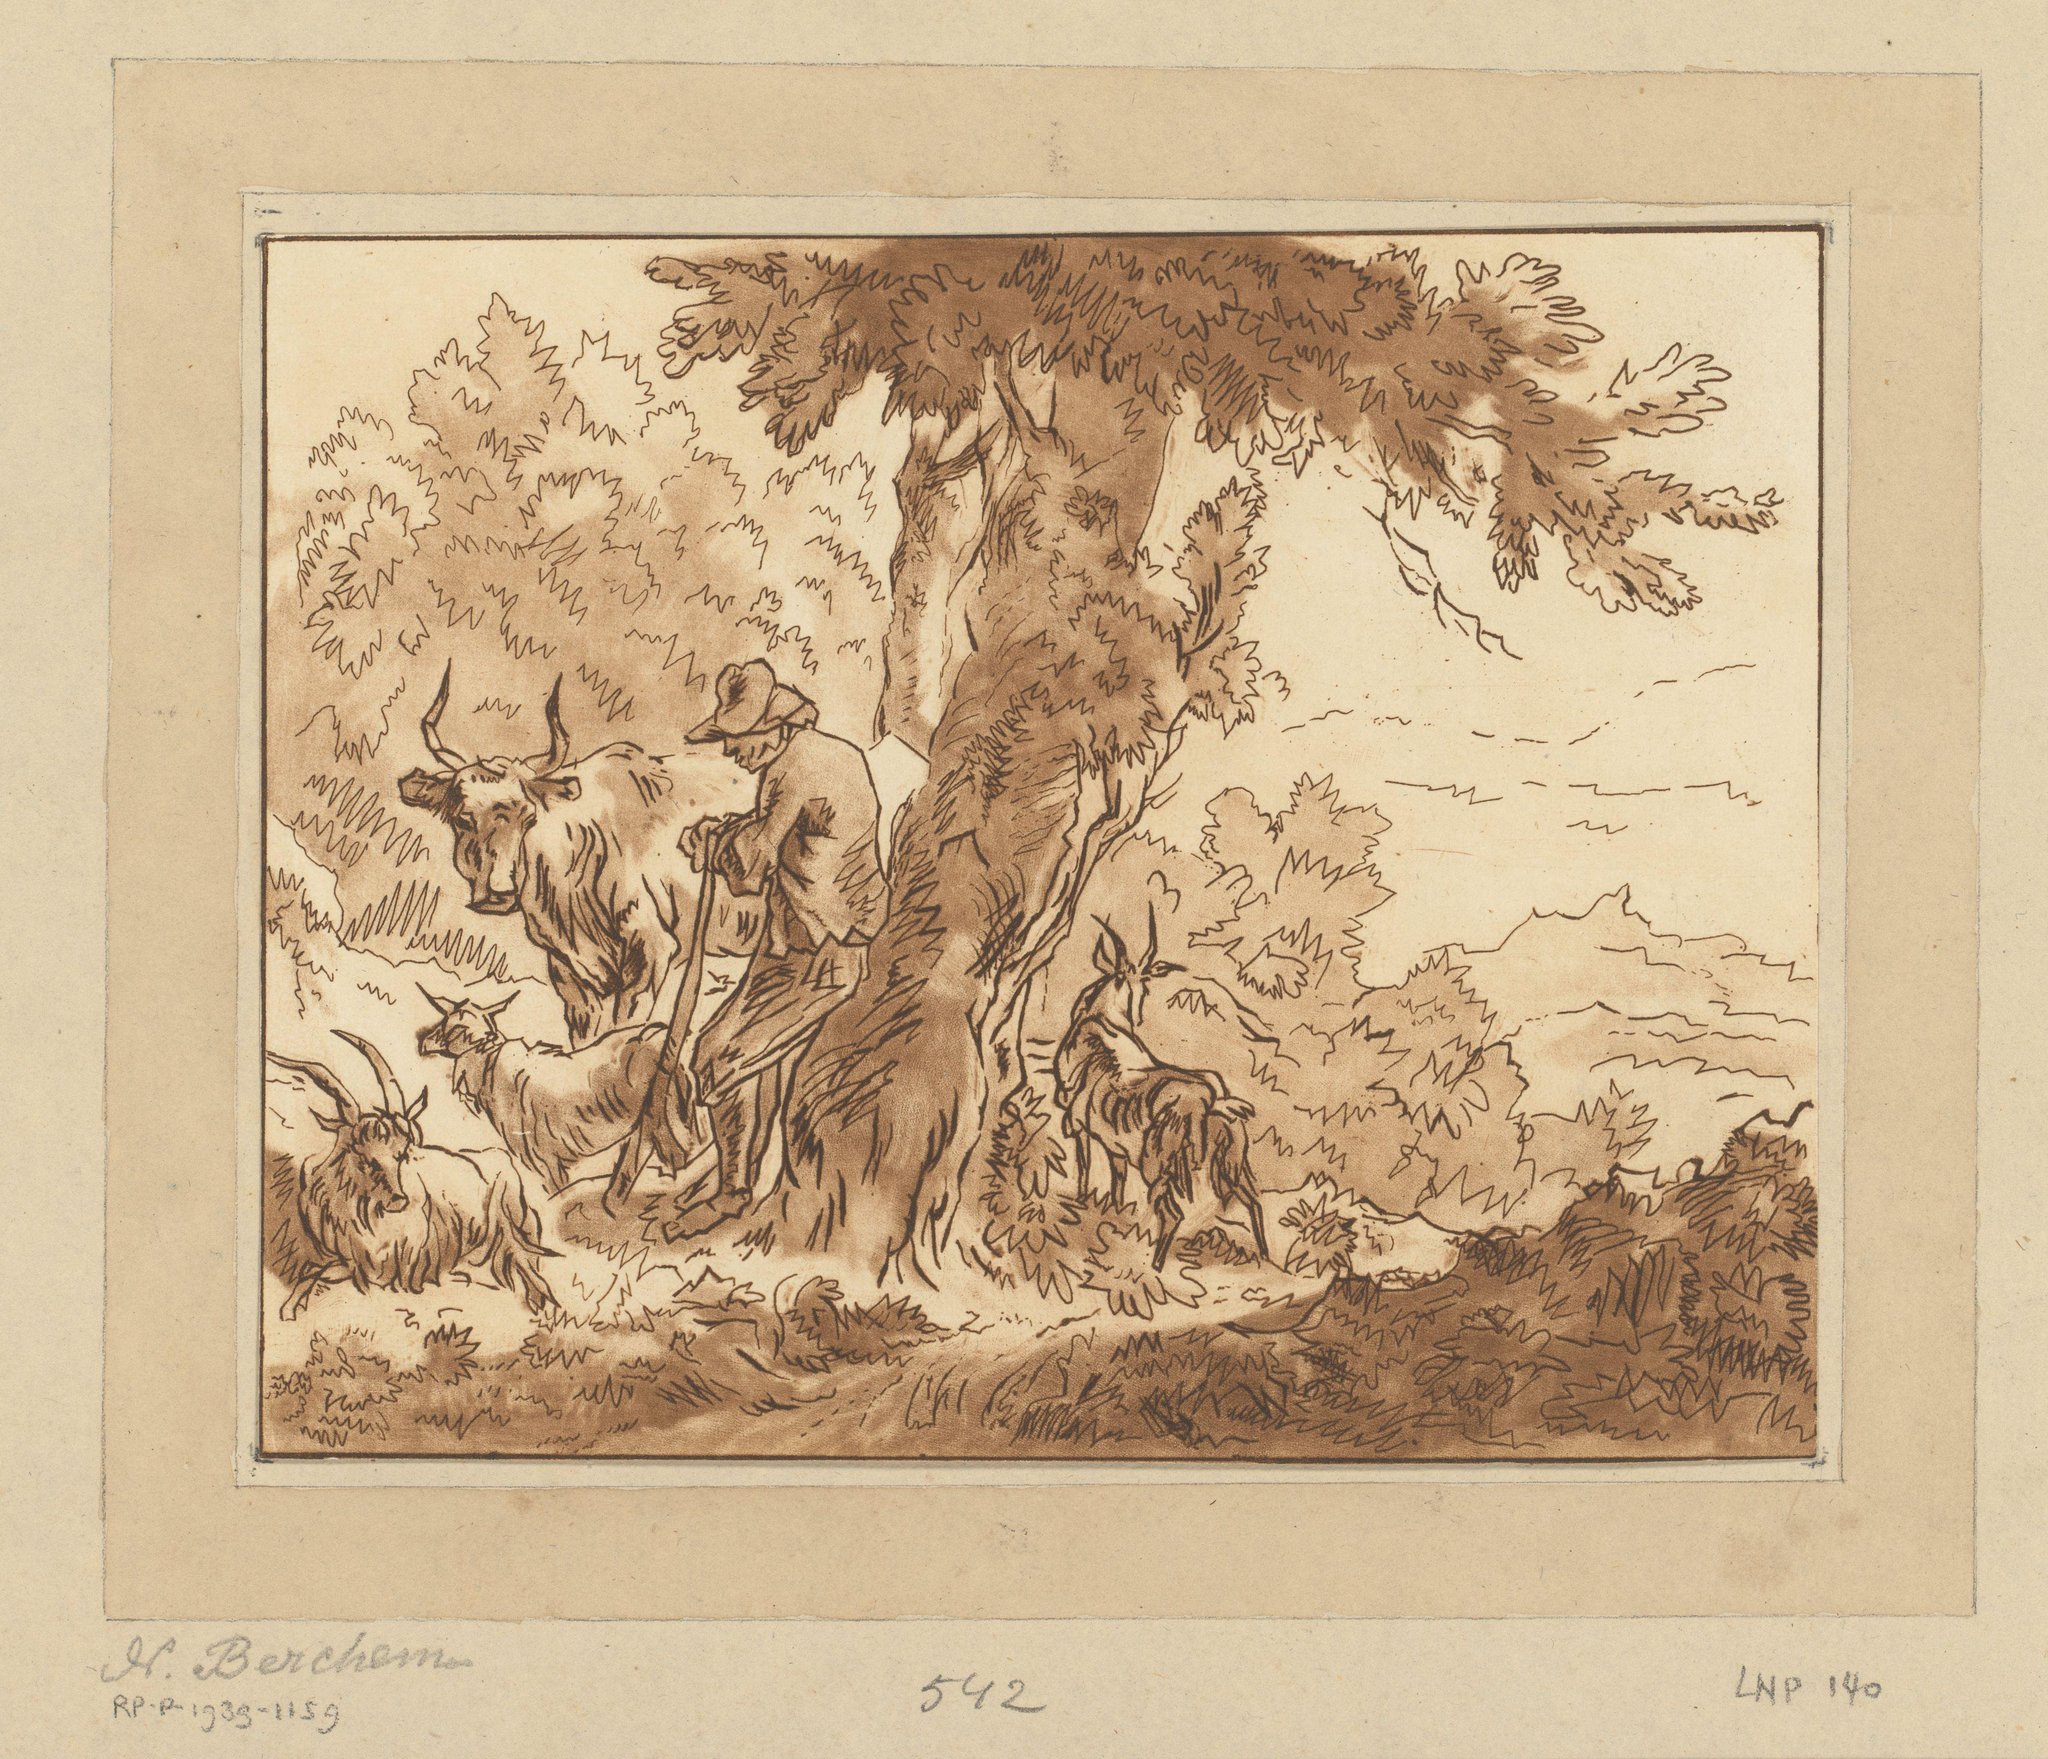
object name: print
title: Herder en zijn vee bij een boom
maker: jacob van de velde (graveur)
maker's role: print maker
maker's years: 1744-1780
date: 1770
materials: paper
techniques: etching, roulette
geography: amsterdam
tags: herding, herdsman, herdswoman, shepherd, shepherdess, cowherd, etc., leaning figure, herd, flock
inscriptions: collector's mark: Lugt 2725, collector's mark: ‘RIJKS / MUSM’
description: De prent werd opgenomen in: Collection d'imitations de dessins d'après les principaux maîtres hollandais et flamands, Londen, C. Josi, 1821.